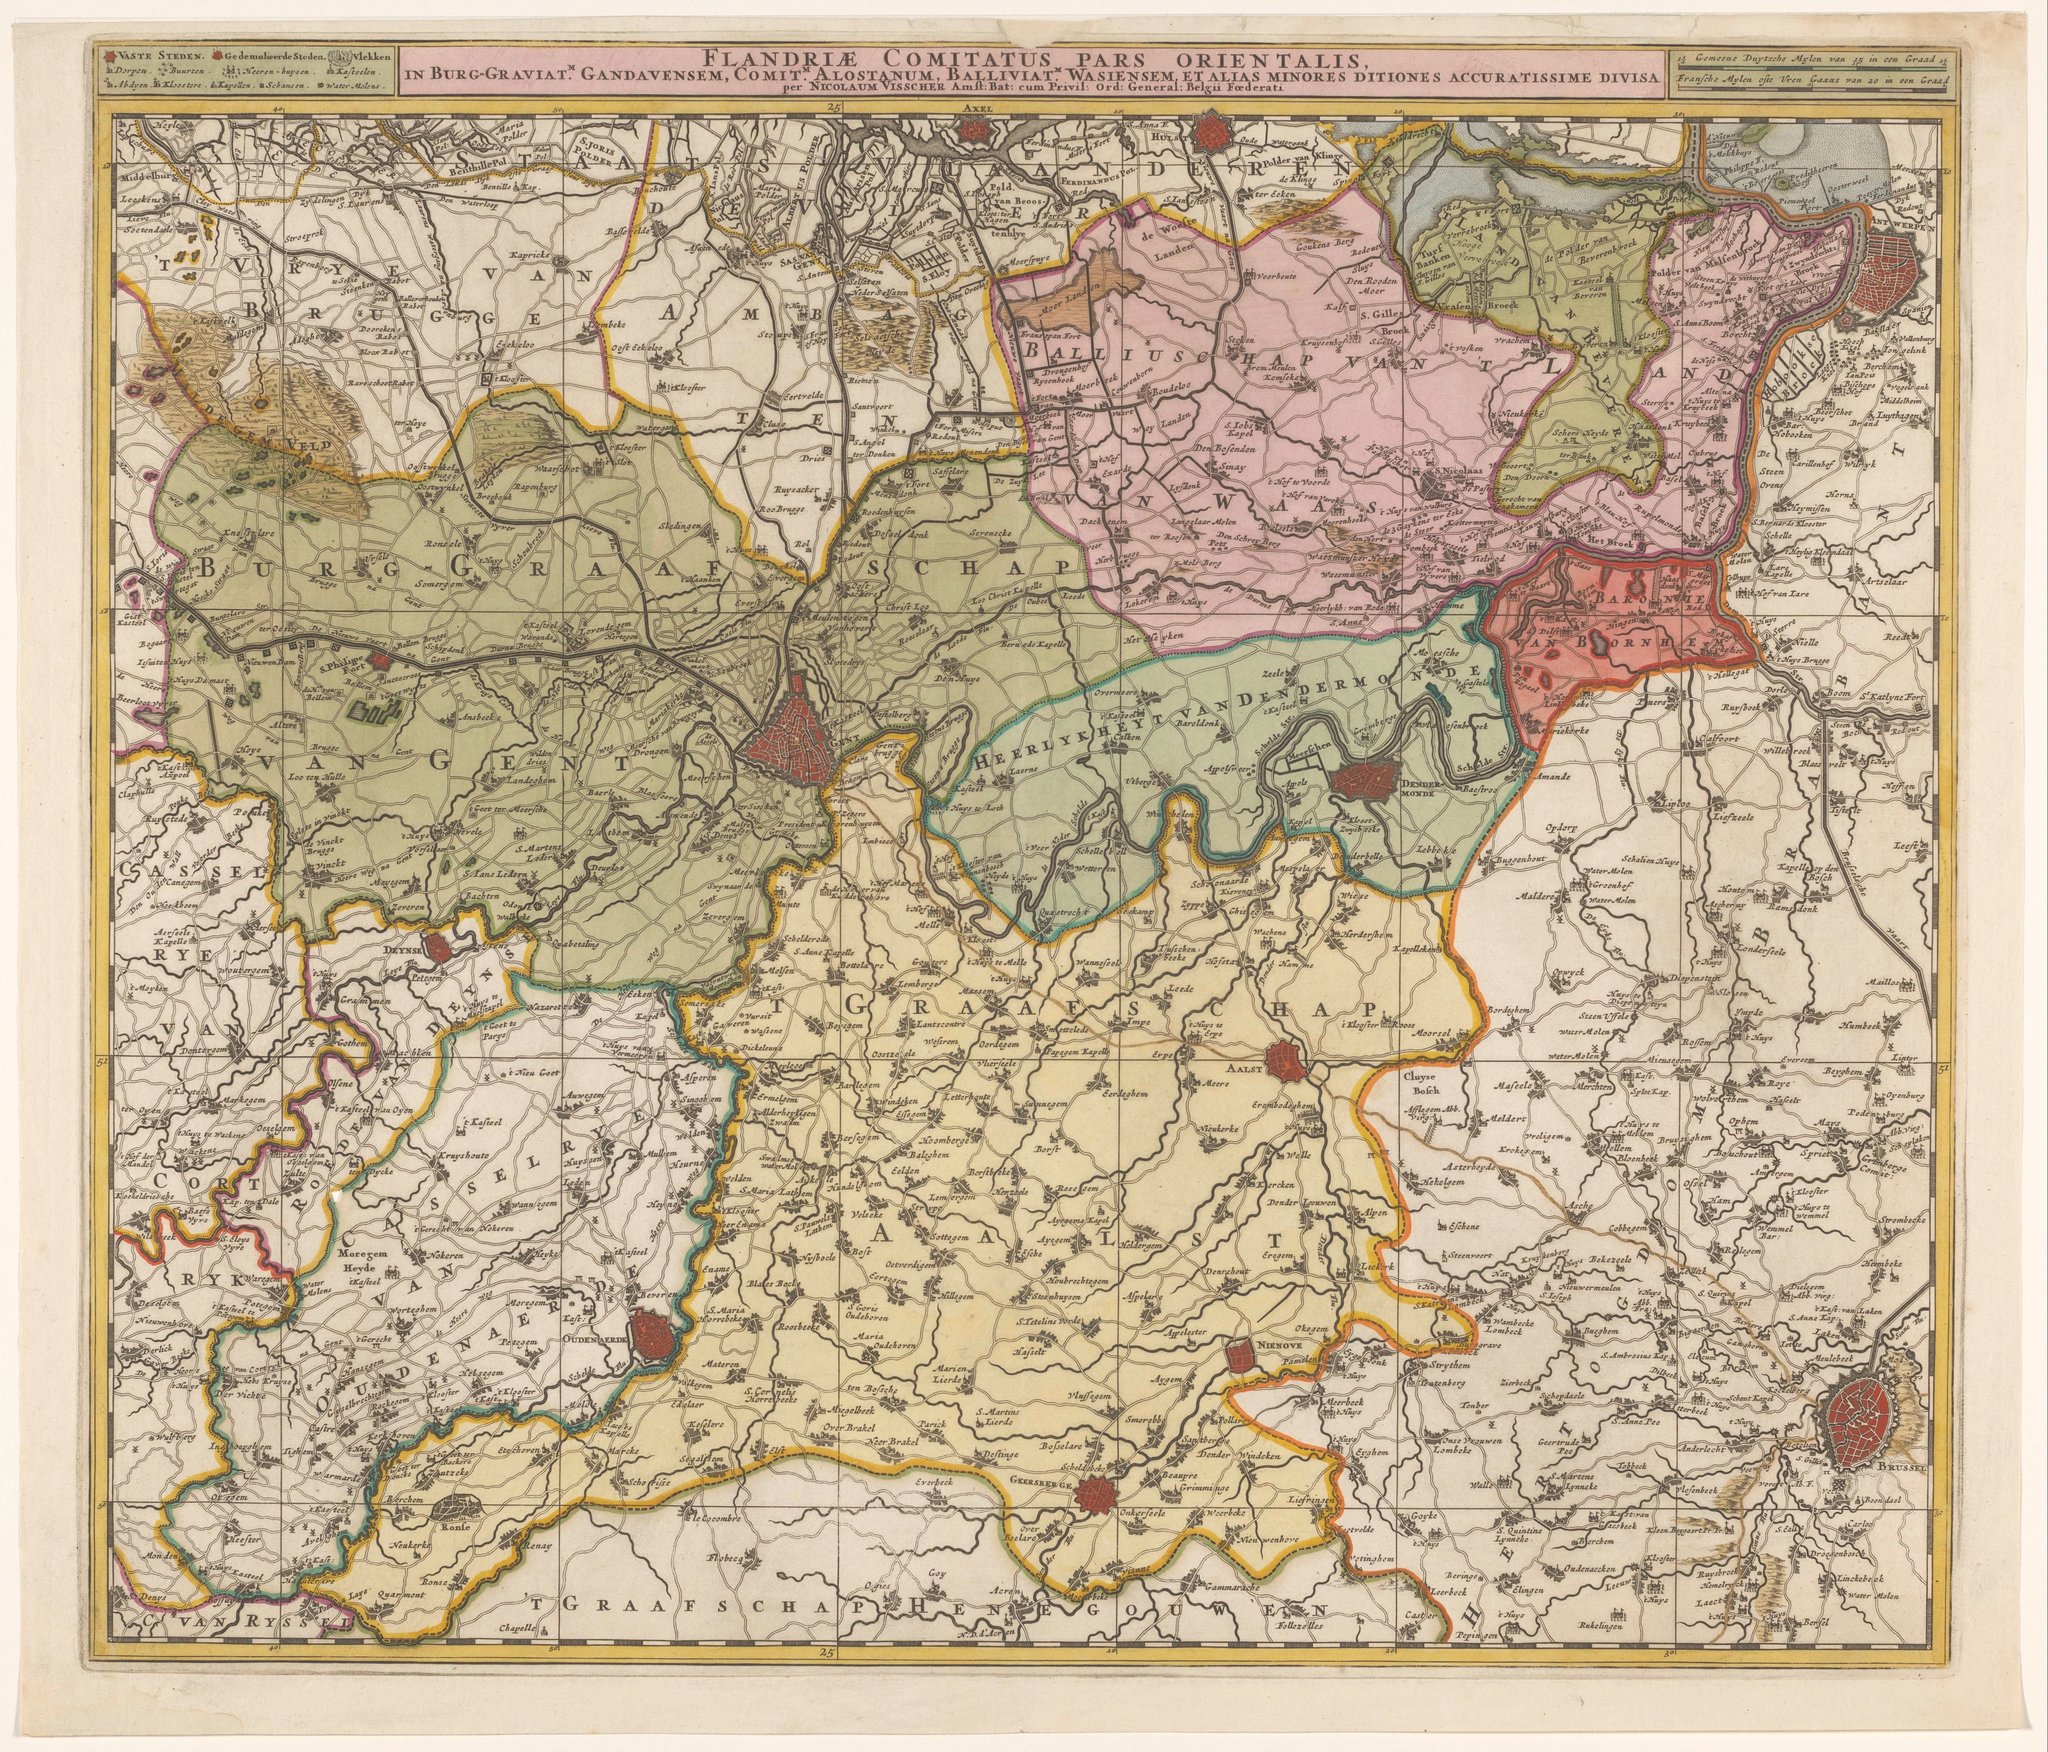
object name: print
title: Kaart van Oost-Vlaanderen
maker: Anonymous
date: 1677-1720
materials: paper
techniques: engraving, etching, hand coloring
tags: maps of separate countries or regions, ghent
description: Kaart van Oost-Vlaanderen. In een balk boven de kaart, in het midden, de titel. Links hiervan een legenda. Rechts van de titel twee schaalstokken: 1 1/2 Gemeene Duytsche Mijlen van 15 in een Graad / 2 Fransche Mylen ofte Uren Gaans van 20 in een Graad. De kaart is voorzien van een coördinaten-net en een gradenverdeling.